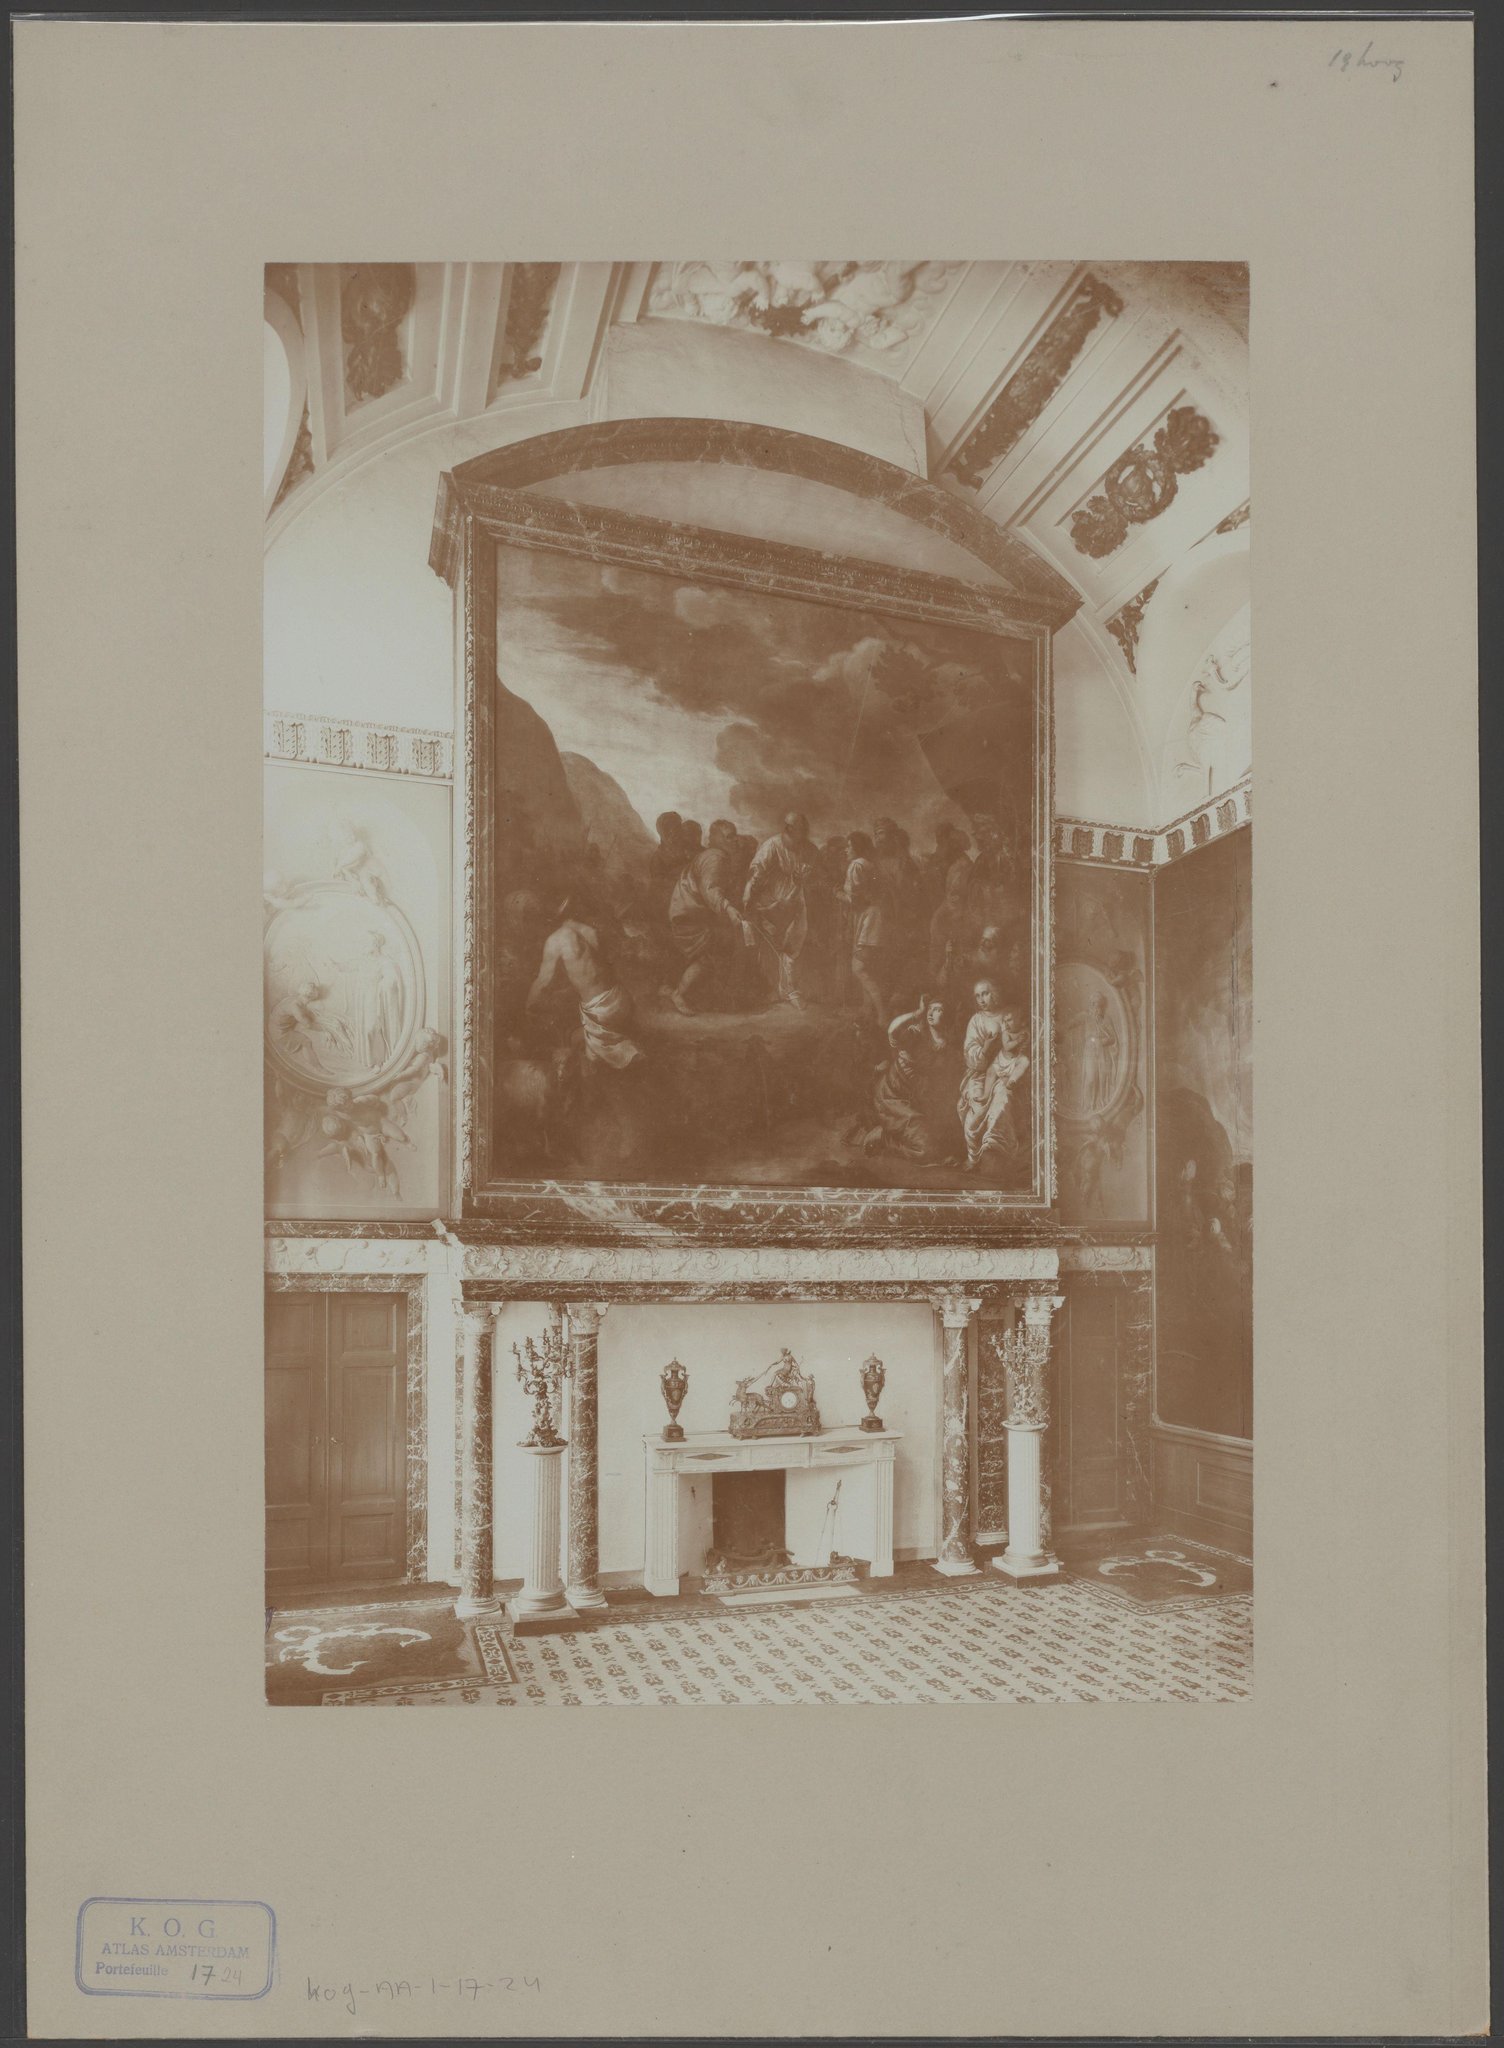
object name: photograph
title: Gezicht op de zuidelijke schoorsteen in de Mozeszaal in het Paleis op de Dam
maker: Anonymous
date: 1865-1940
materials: paper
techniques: collodion silver print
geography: amsterdam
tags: chimney, townhall, chimney-piece, mantelpiece, royal palace of amsterdam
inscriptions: collector's mark: ‘17.24’ Lugt 1641b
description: Onderwerpsrubriek binnen de Atlas Amsterdam: Nieuwe Stadhuis, van binnen: Groote zaal, Raadkamer, Schepenkamer, Troonzaal, Mozeszaal, Zitkamer.